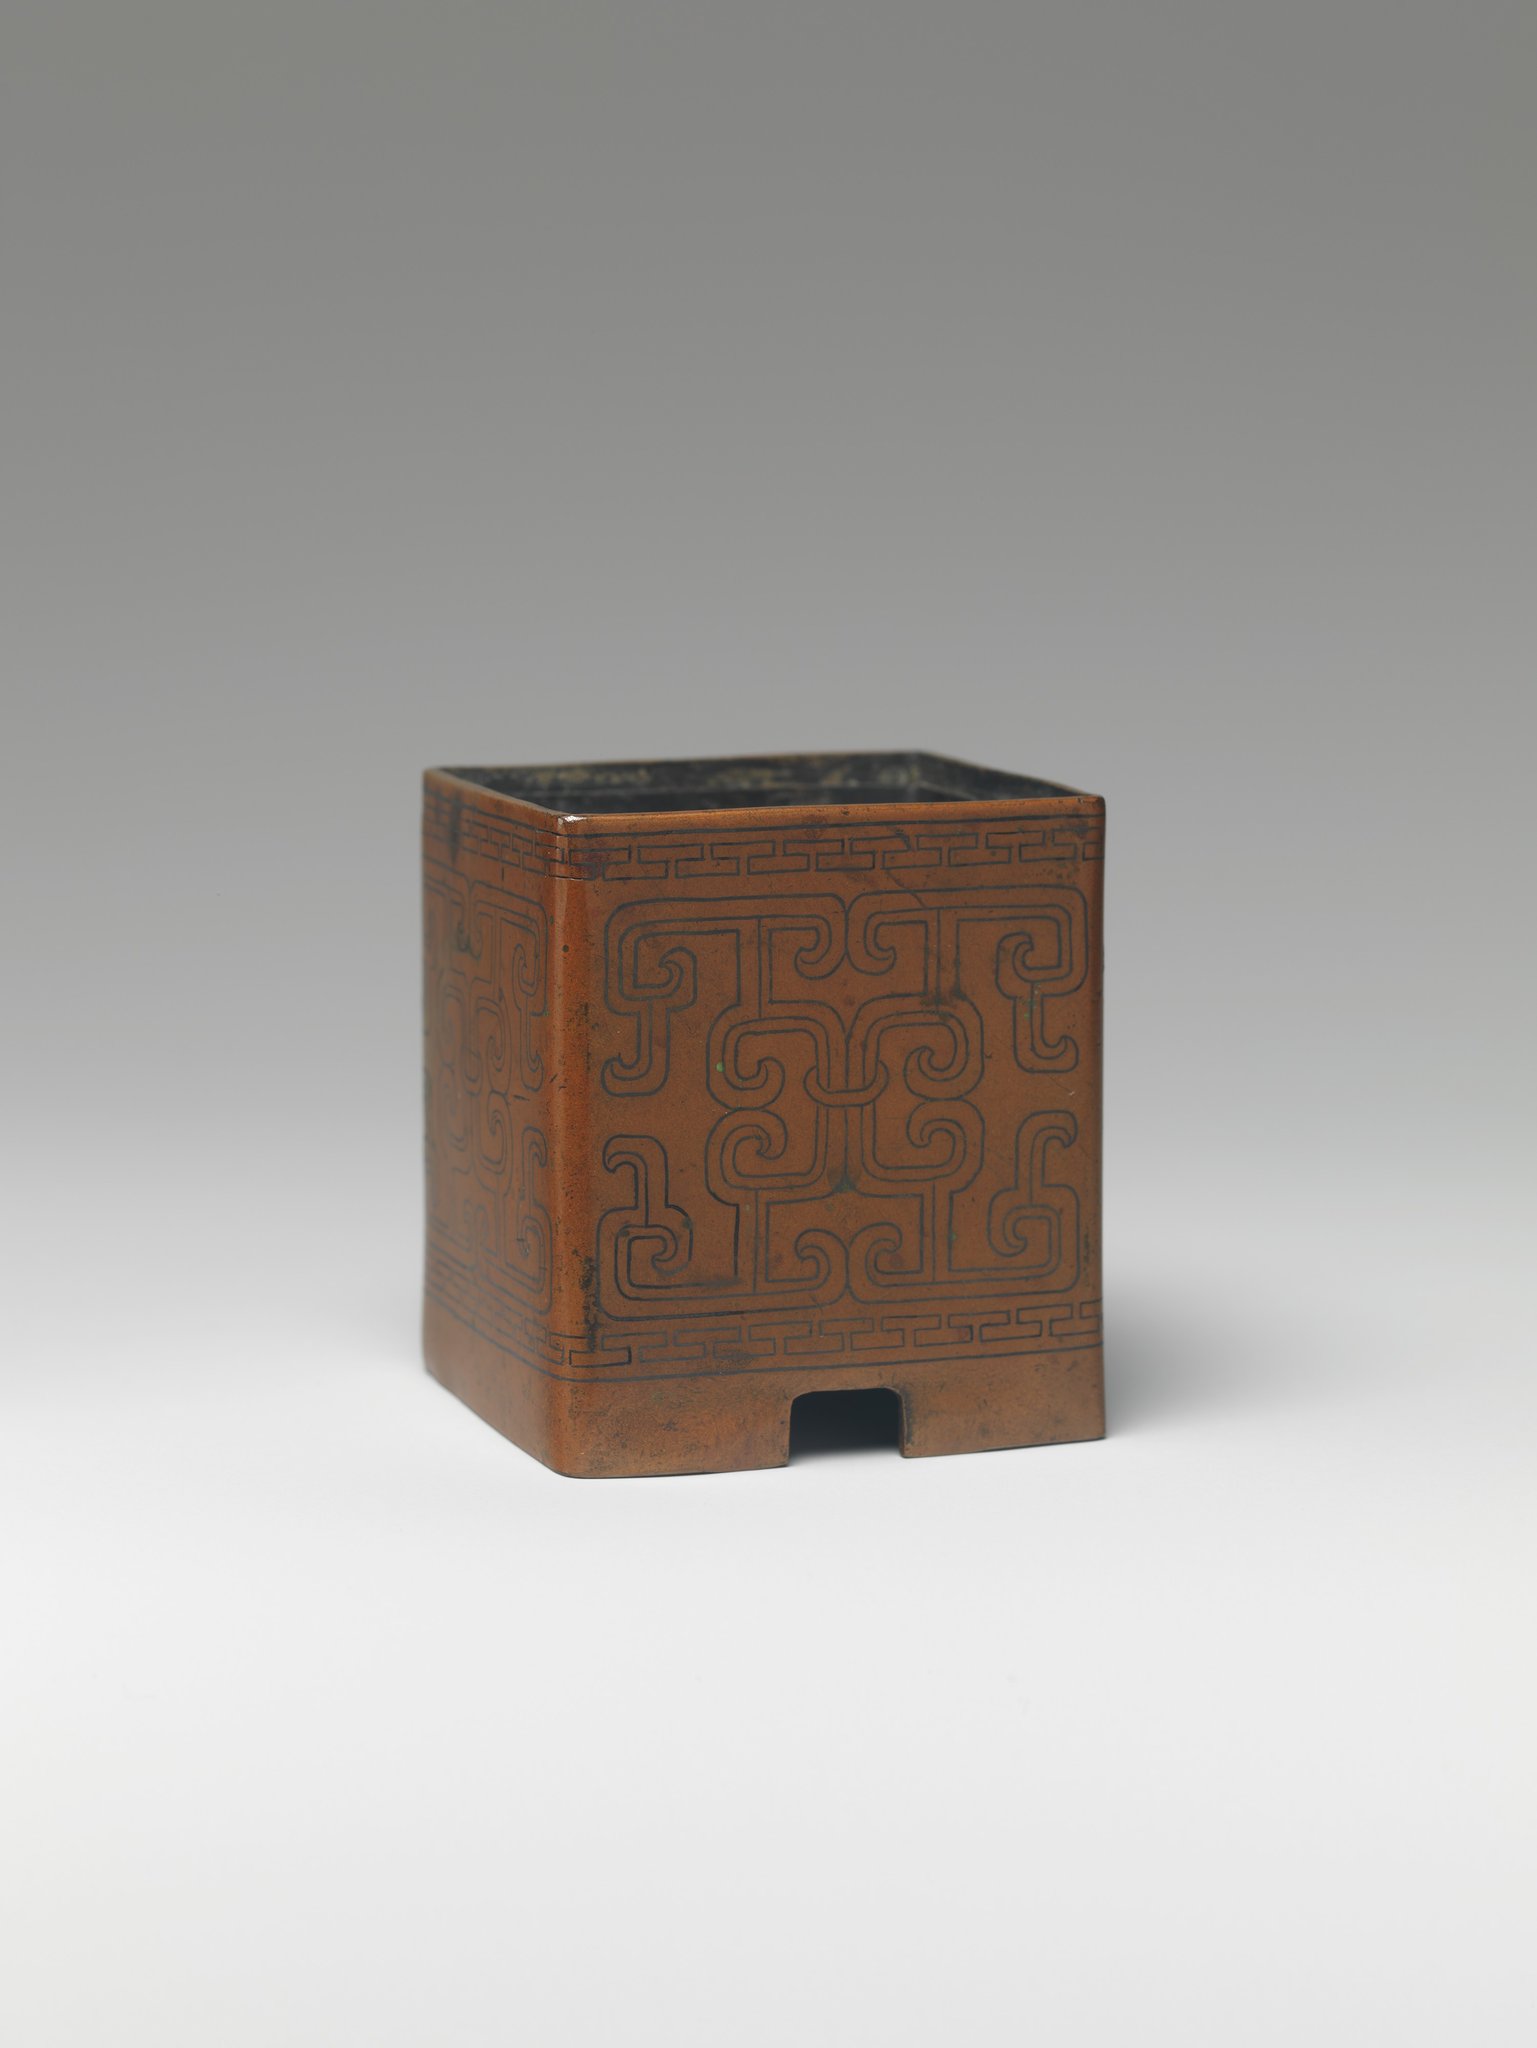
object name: incense burner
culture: chinese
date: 1701-1800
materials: bronze